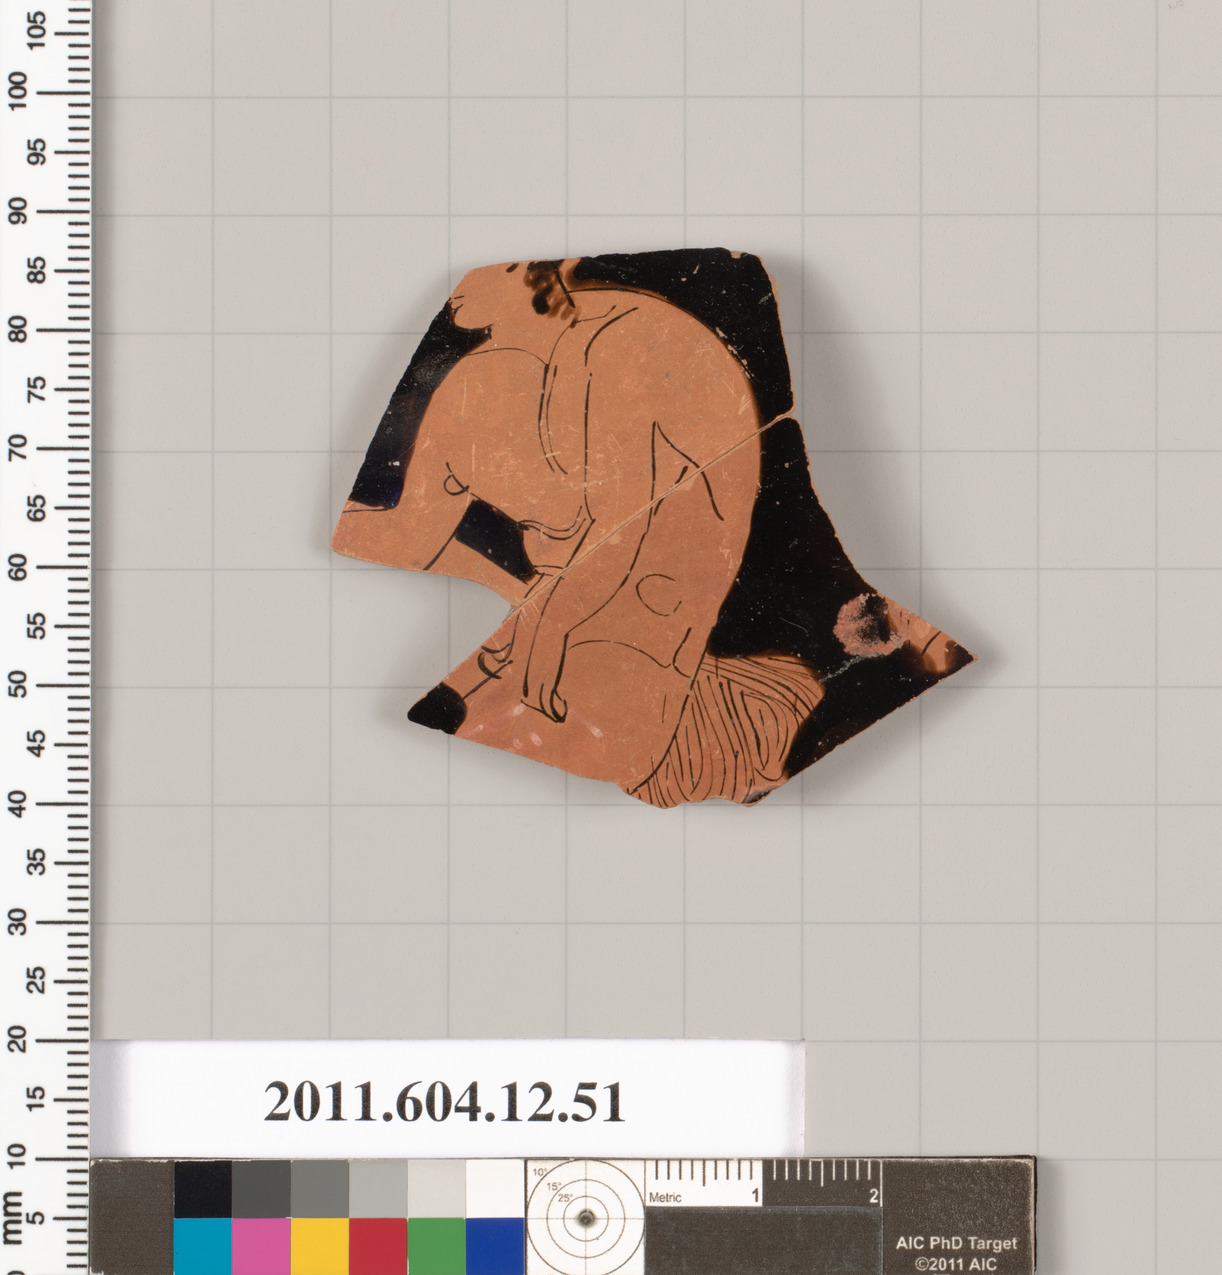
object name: undetermined closed shape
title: Terracotta fragment of a closed shape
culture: greek or south italian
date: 400-301 BCE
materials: terracotta